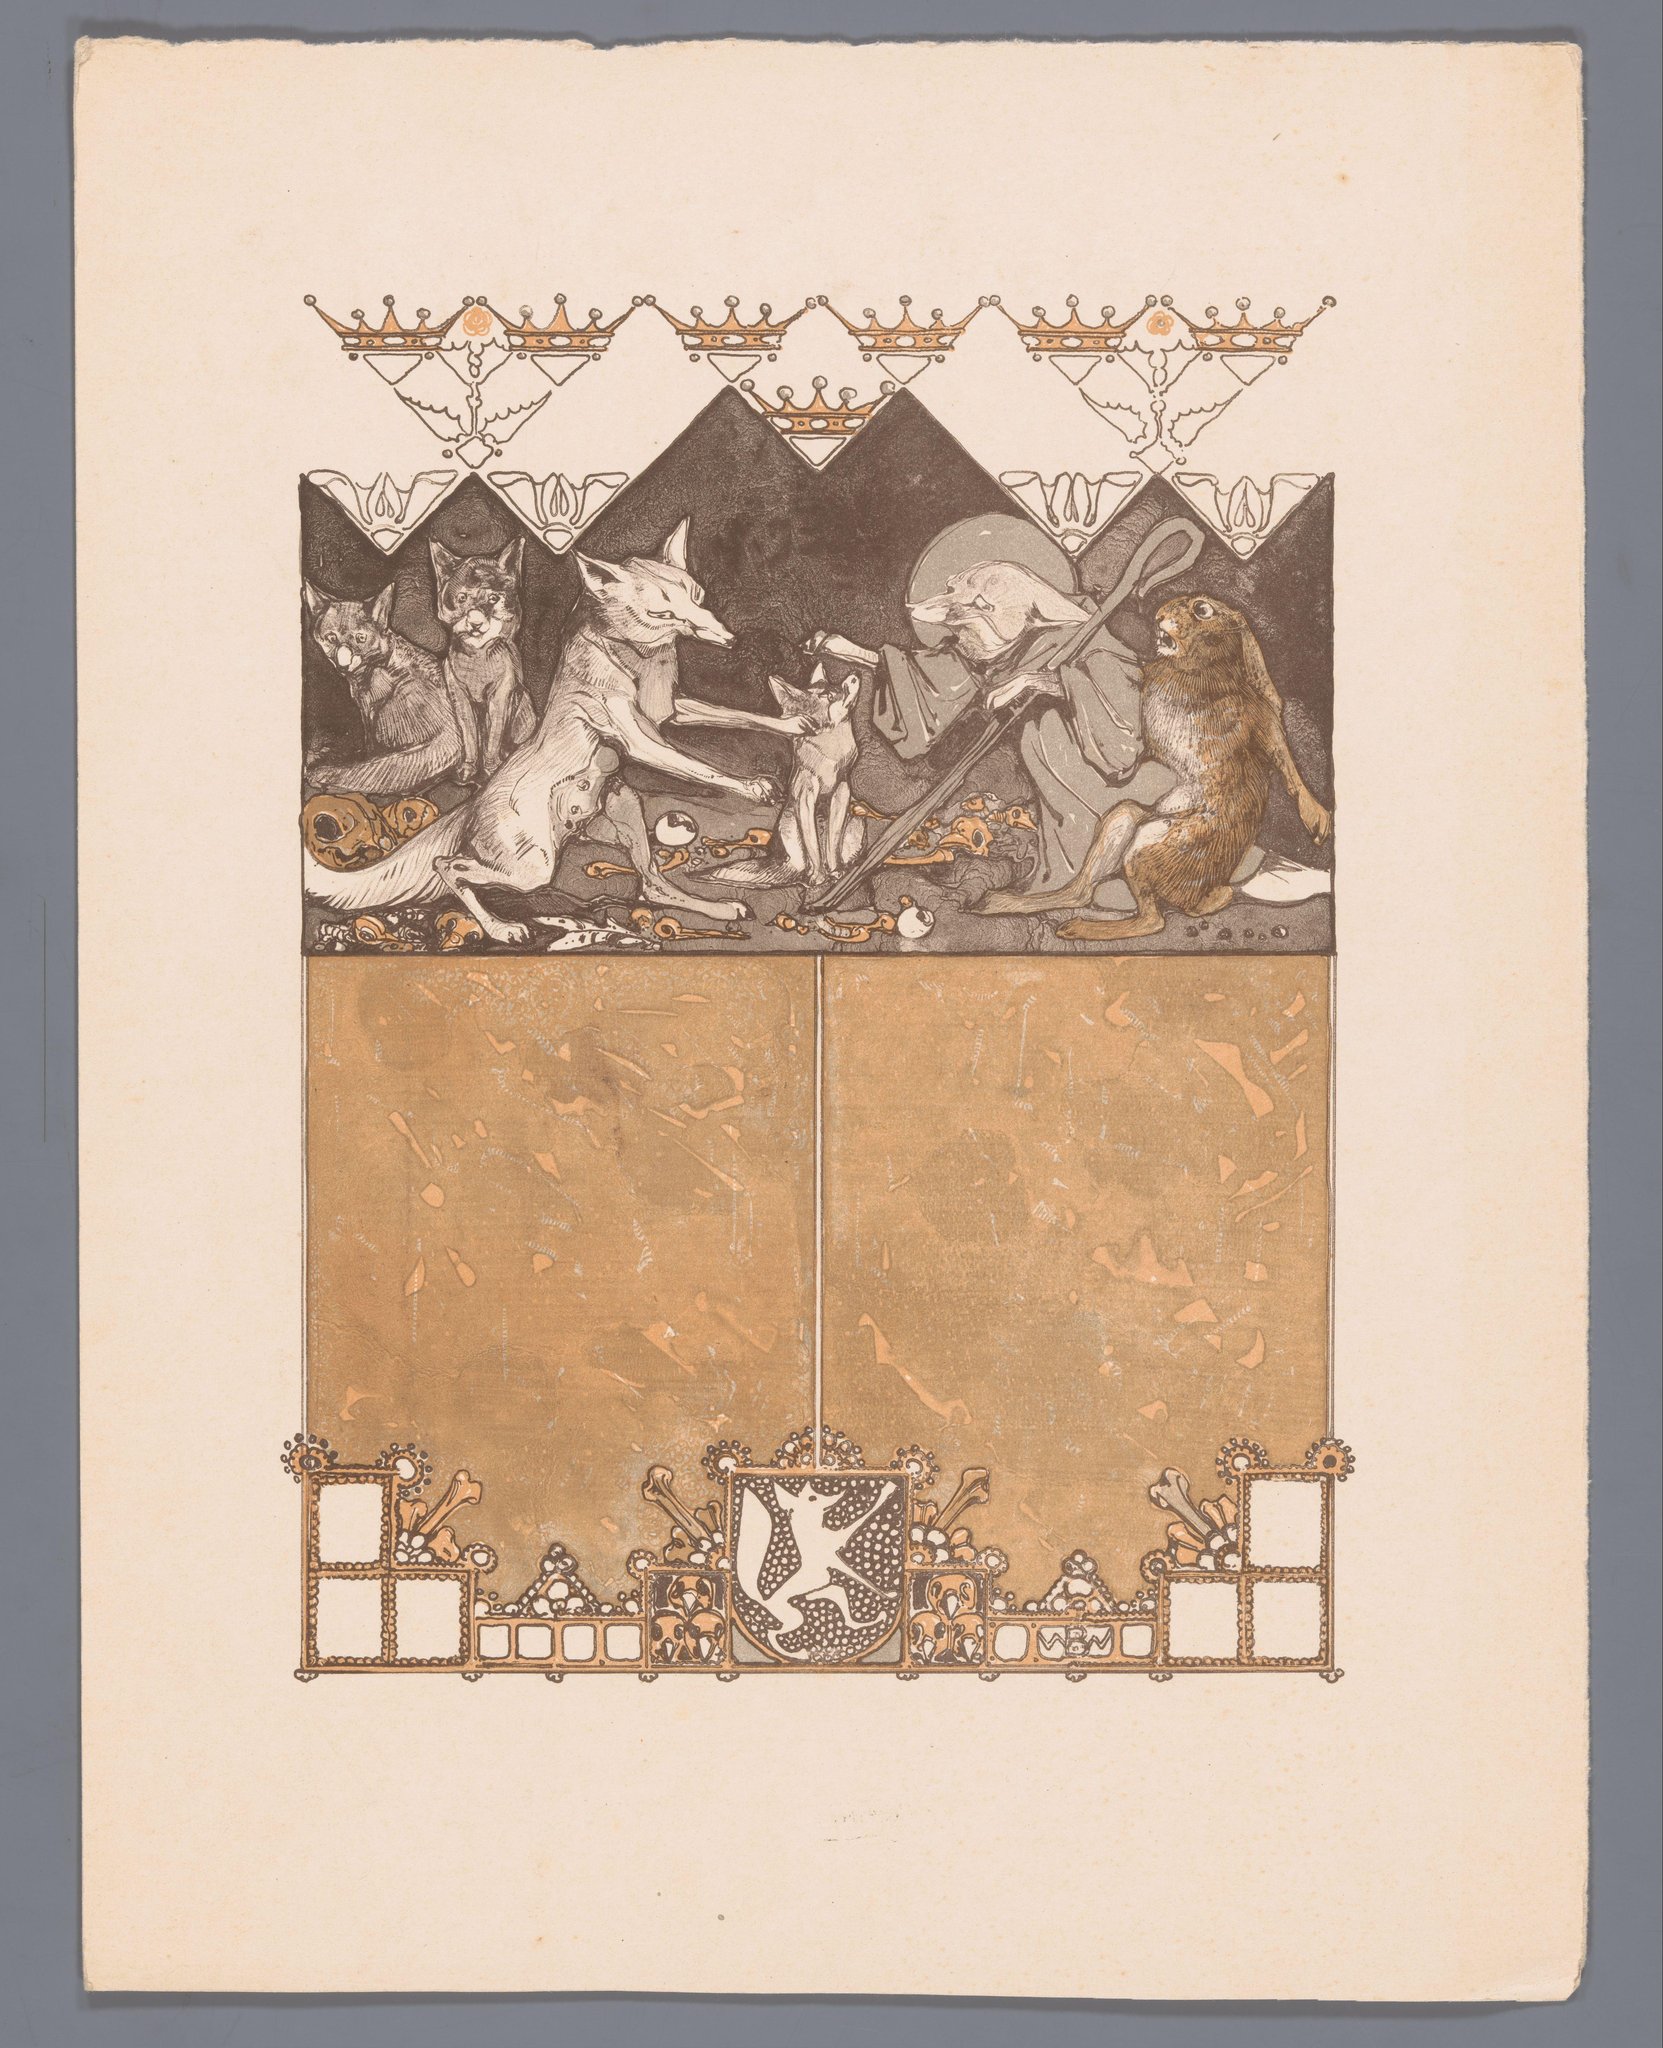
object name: boekillustratie ontwerp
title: Vos in monnikspij (Reinaert) met haas (Cuwaert) bij vossin (Hermeline) en welpen in vossenhol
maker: bernard willem wierink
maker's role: draughtsman, print maker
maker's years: 1856-1939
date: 1910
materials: paper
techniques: lithograph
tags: fable of reynard the fox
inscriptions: collector's mark: Lugt 2228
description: Ontwerp voor: Streuvels, Stijn (Frank Lateur). Reinaert de Vos naar verschillende uitgaven van het middeleeuwsche epos. Amsterdam: L.J. Veen, 1910.